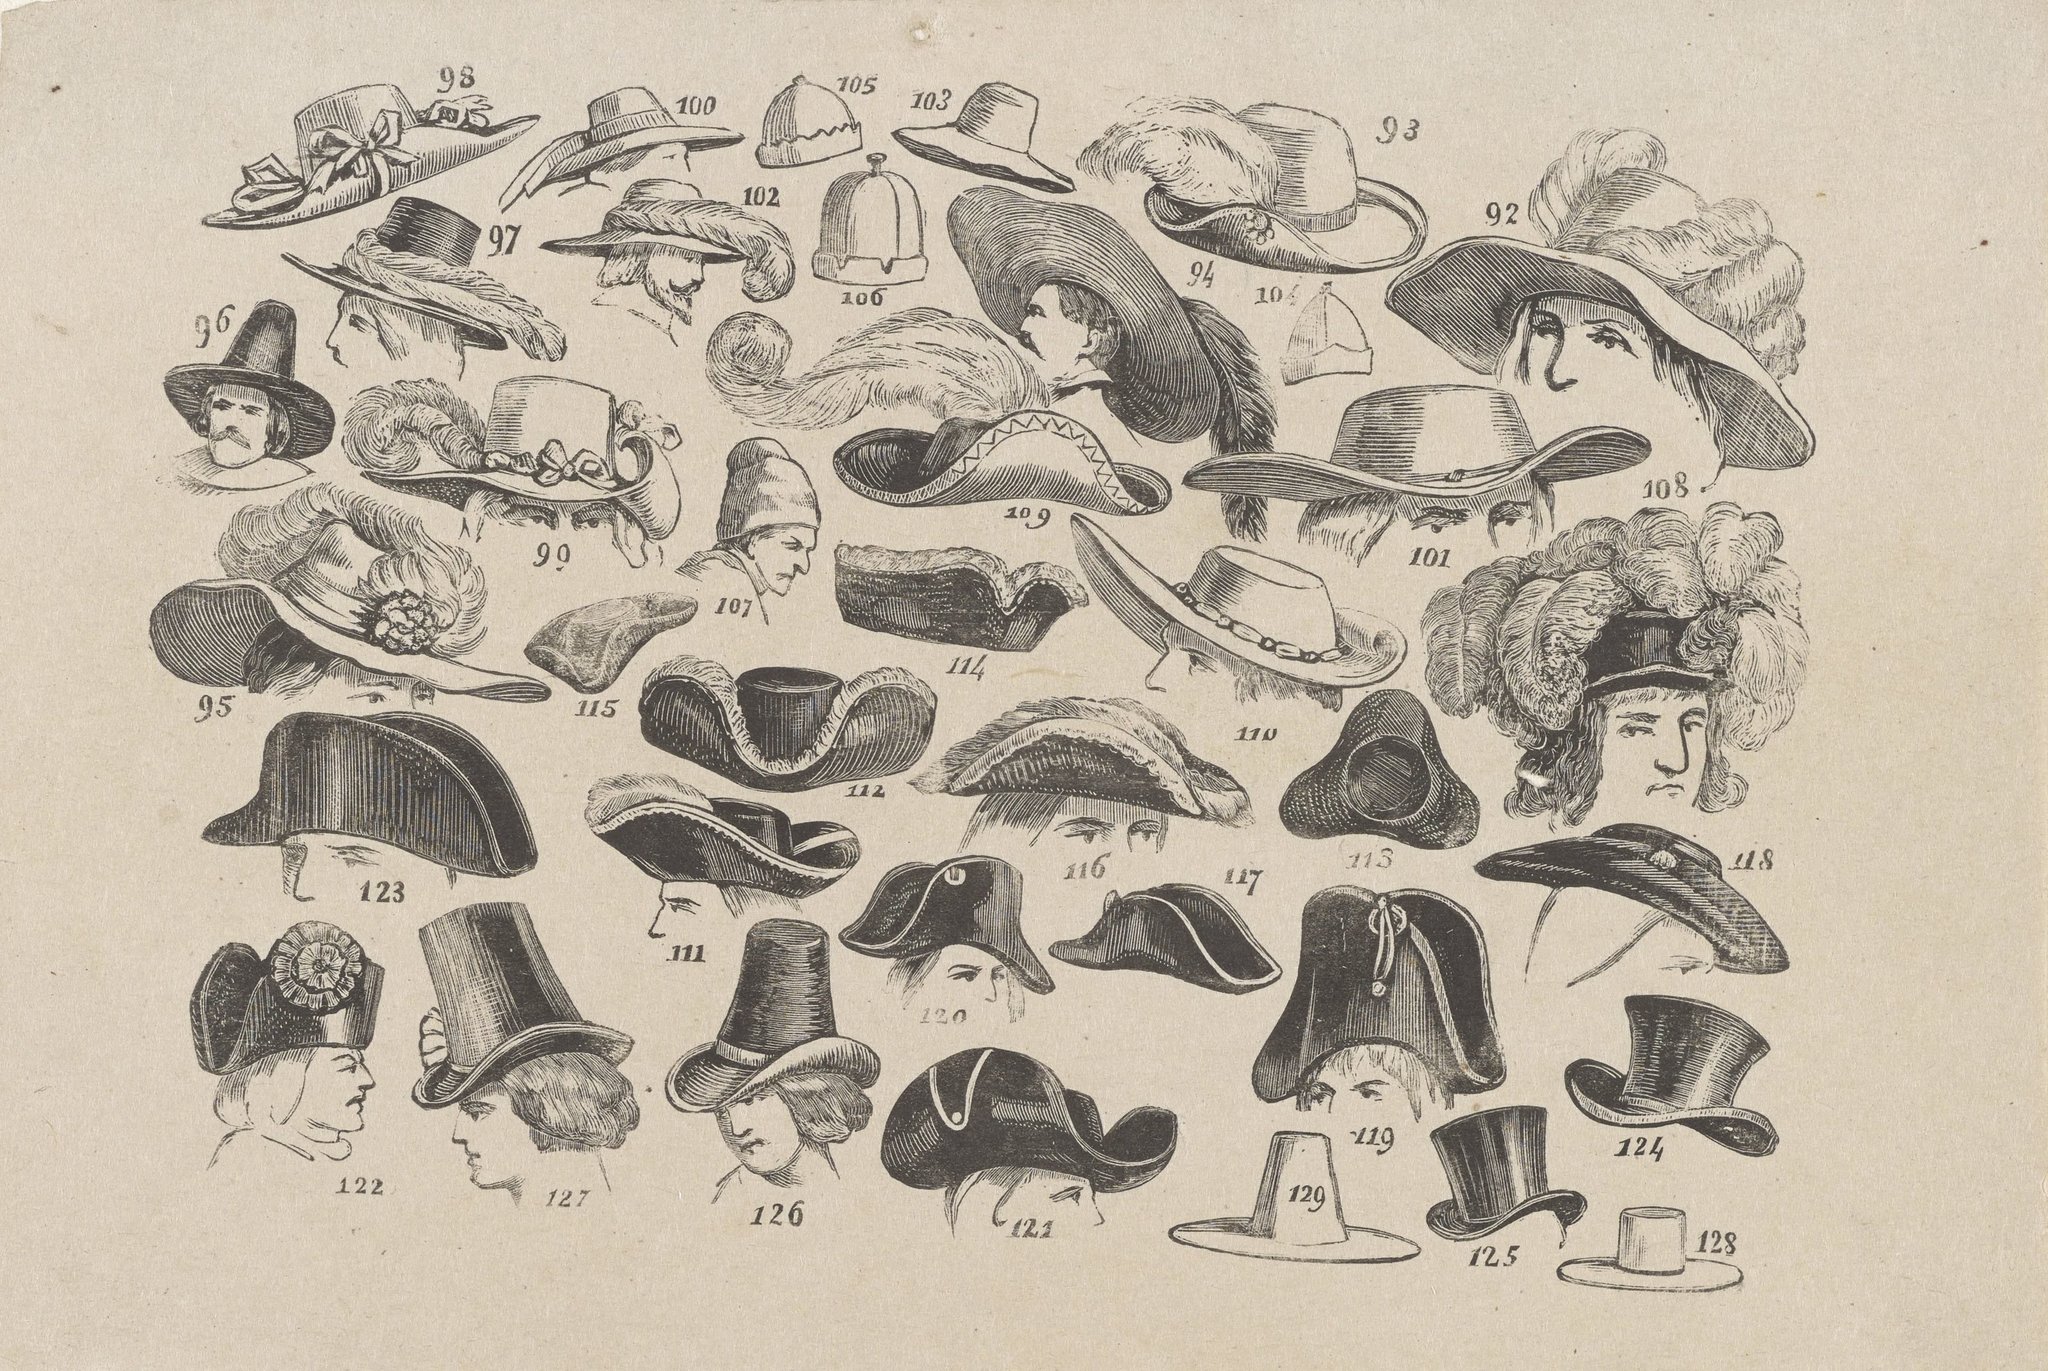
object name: print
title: Verschillende soorten hoeden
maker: isaac weissenbruch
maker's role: print maker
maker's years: 1826-1912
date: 1836-1912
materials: paper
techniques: engraving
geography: netherlands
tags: head-gear